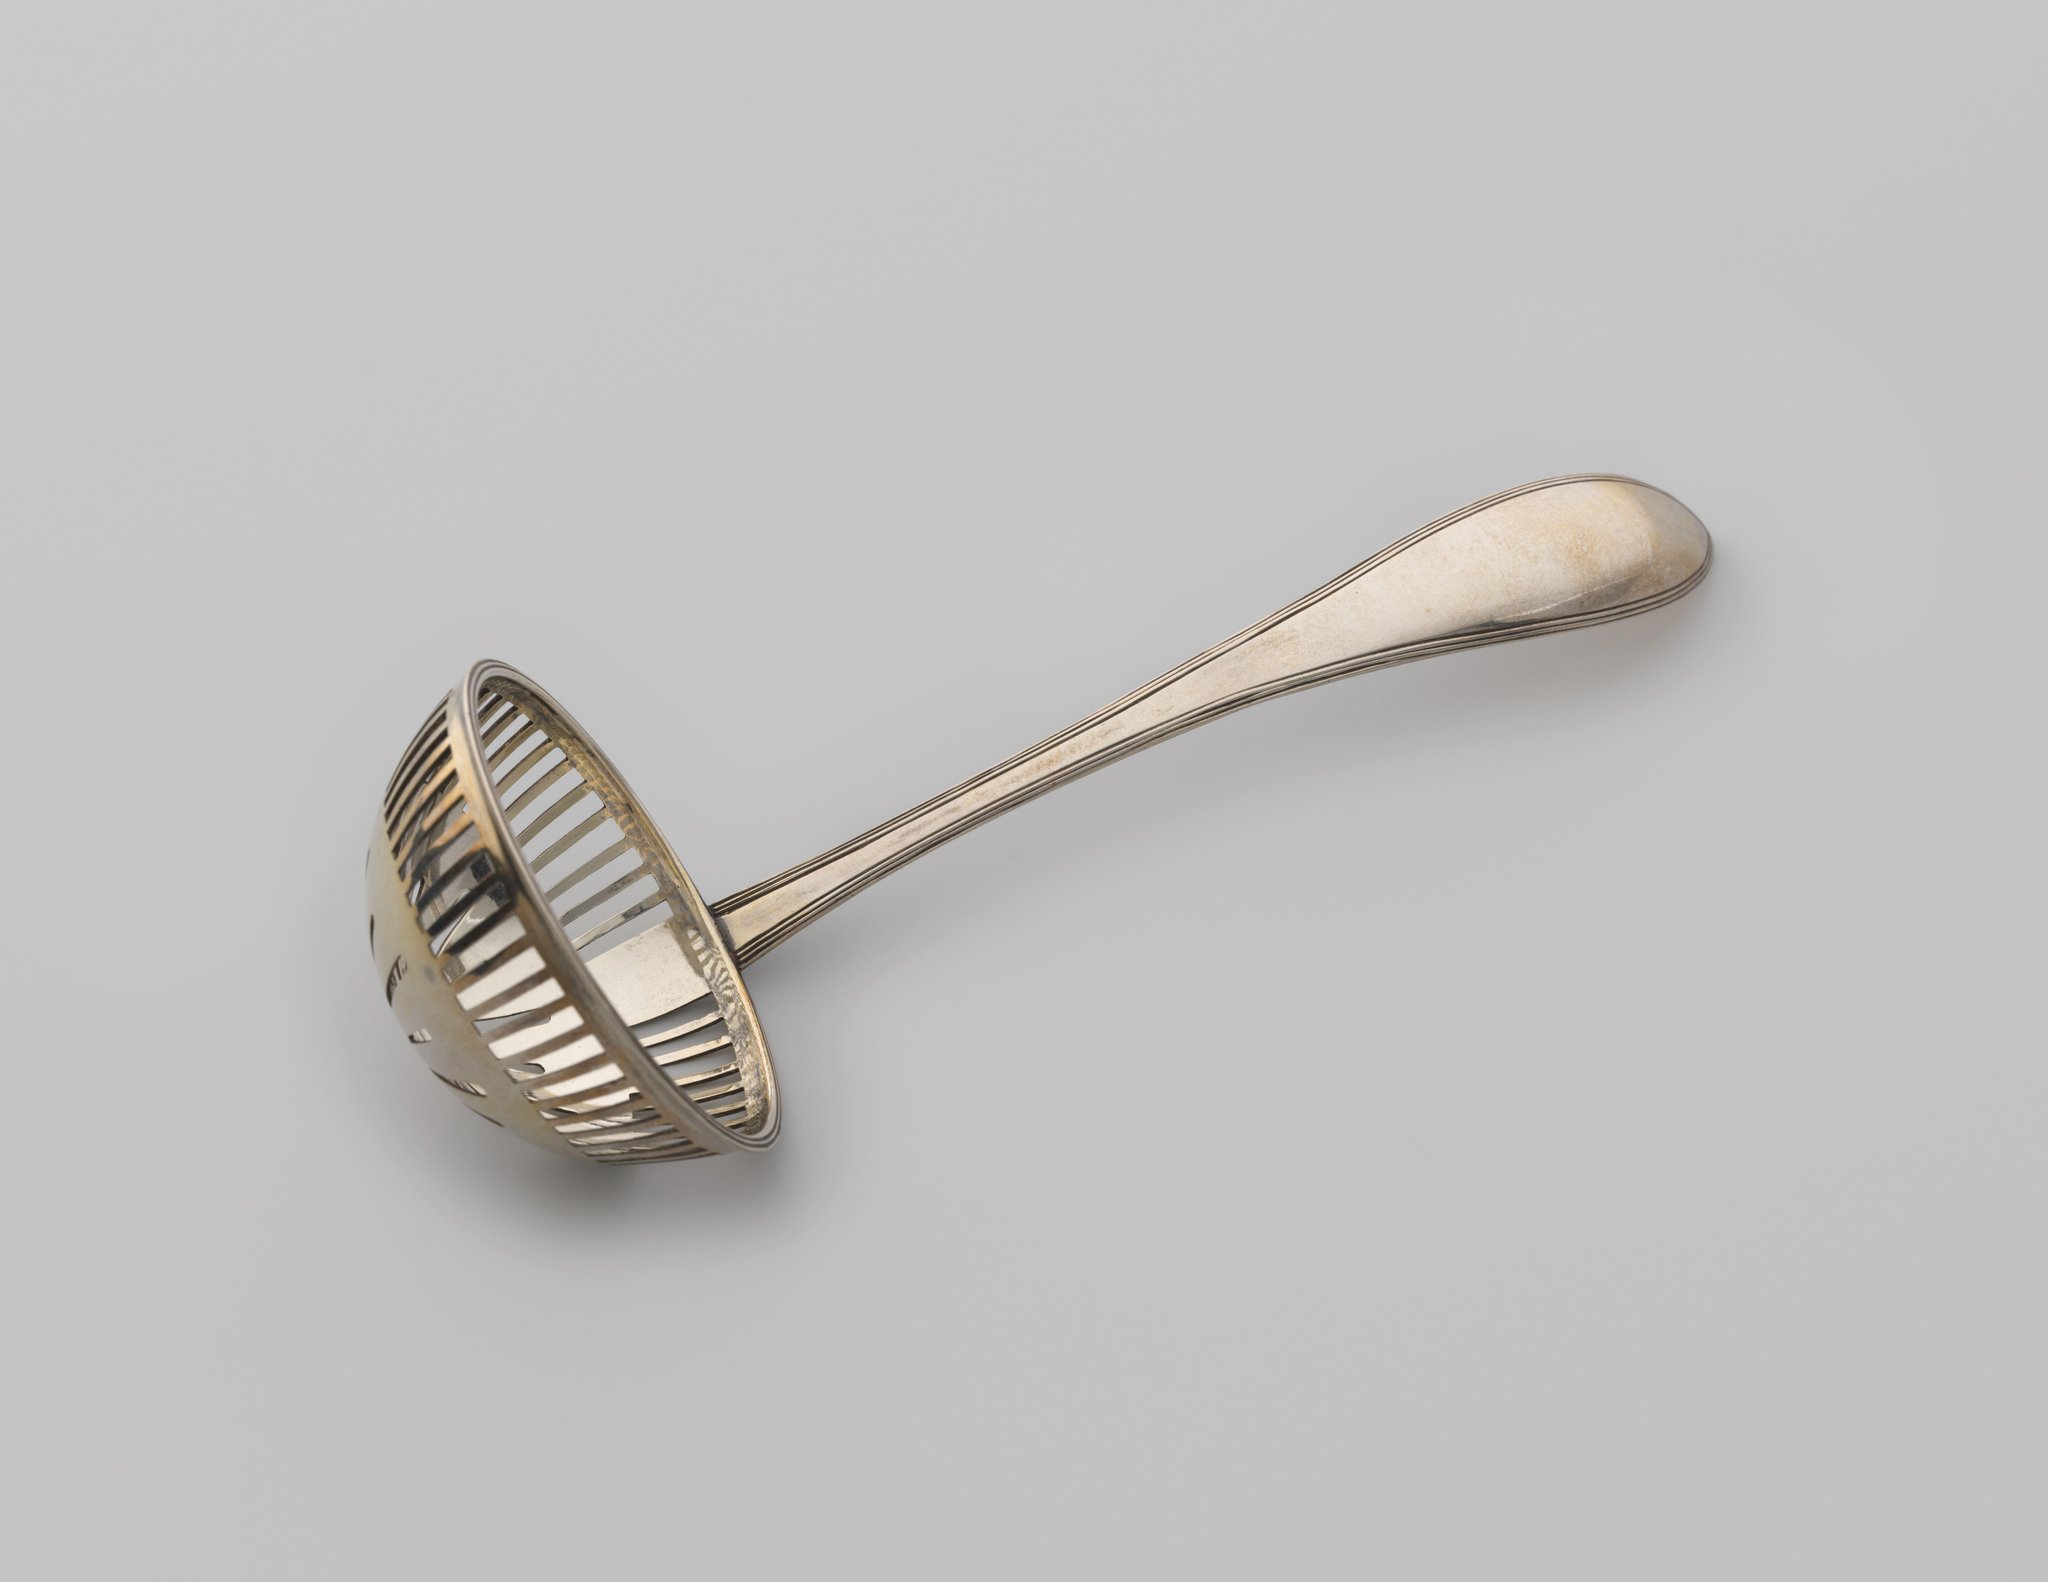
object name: spoon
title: Suikerstrooilepel met ronde, opengewerkte bak en steel met spits toelopend uiteinde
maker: theodorus gerardus bentvelt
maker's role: silversmith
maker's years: 1782-1853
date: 1807-1809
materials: silver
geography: amsterdam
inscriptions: date letter: ‘A’, maker's mark, alloy mark, town mark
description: De diepe, ronde bak wordt omgeven door een platte filetrand. Hij is opengewerkt met een patroon van afwisselend korte en lange stralen binnen een rand van rechte spijlen. De bak is door middel van enkel lof verbonden met de platte, gebogen steel, die zich verbreedt naar het spits toelopende uiteinde en die aan de bovenzijde omgeven wordt door een filetrand.